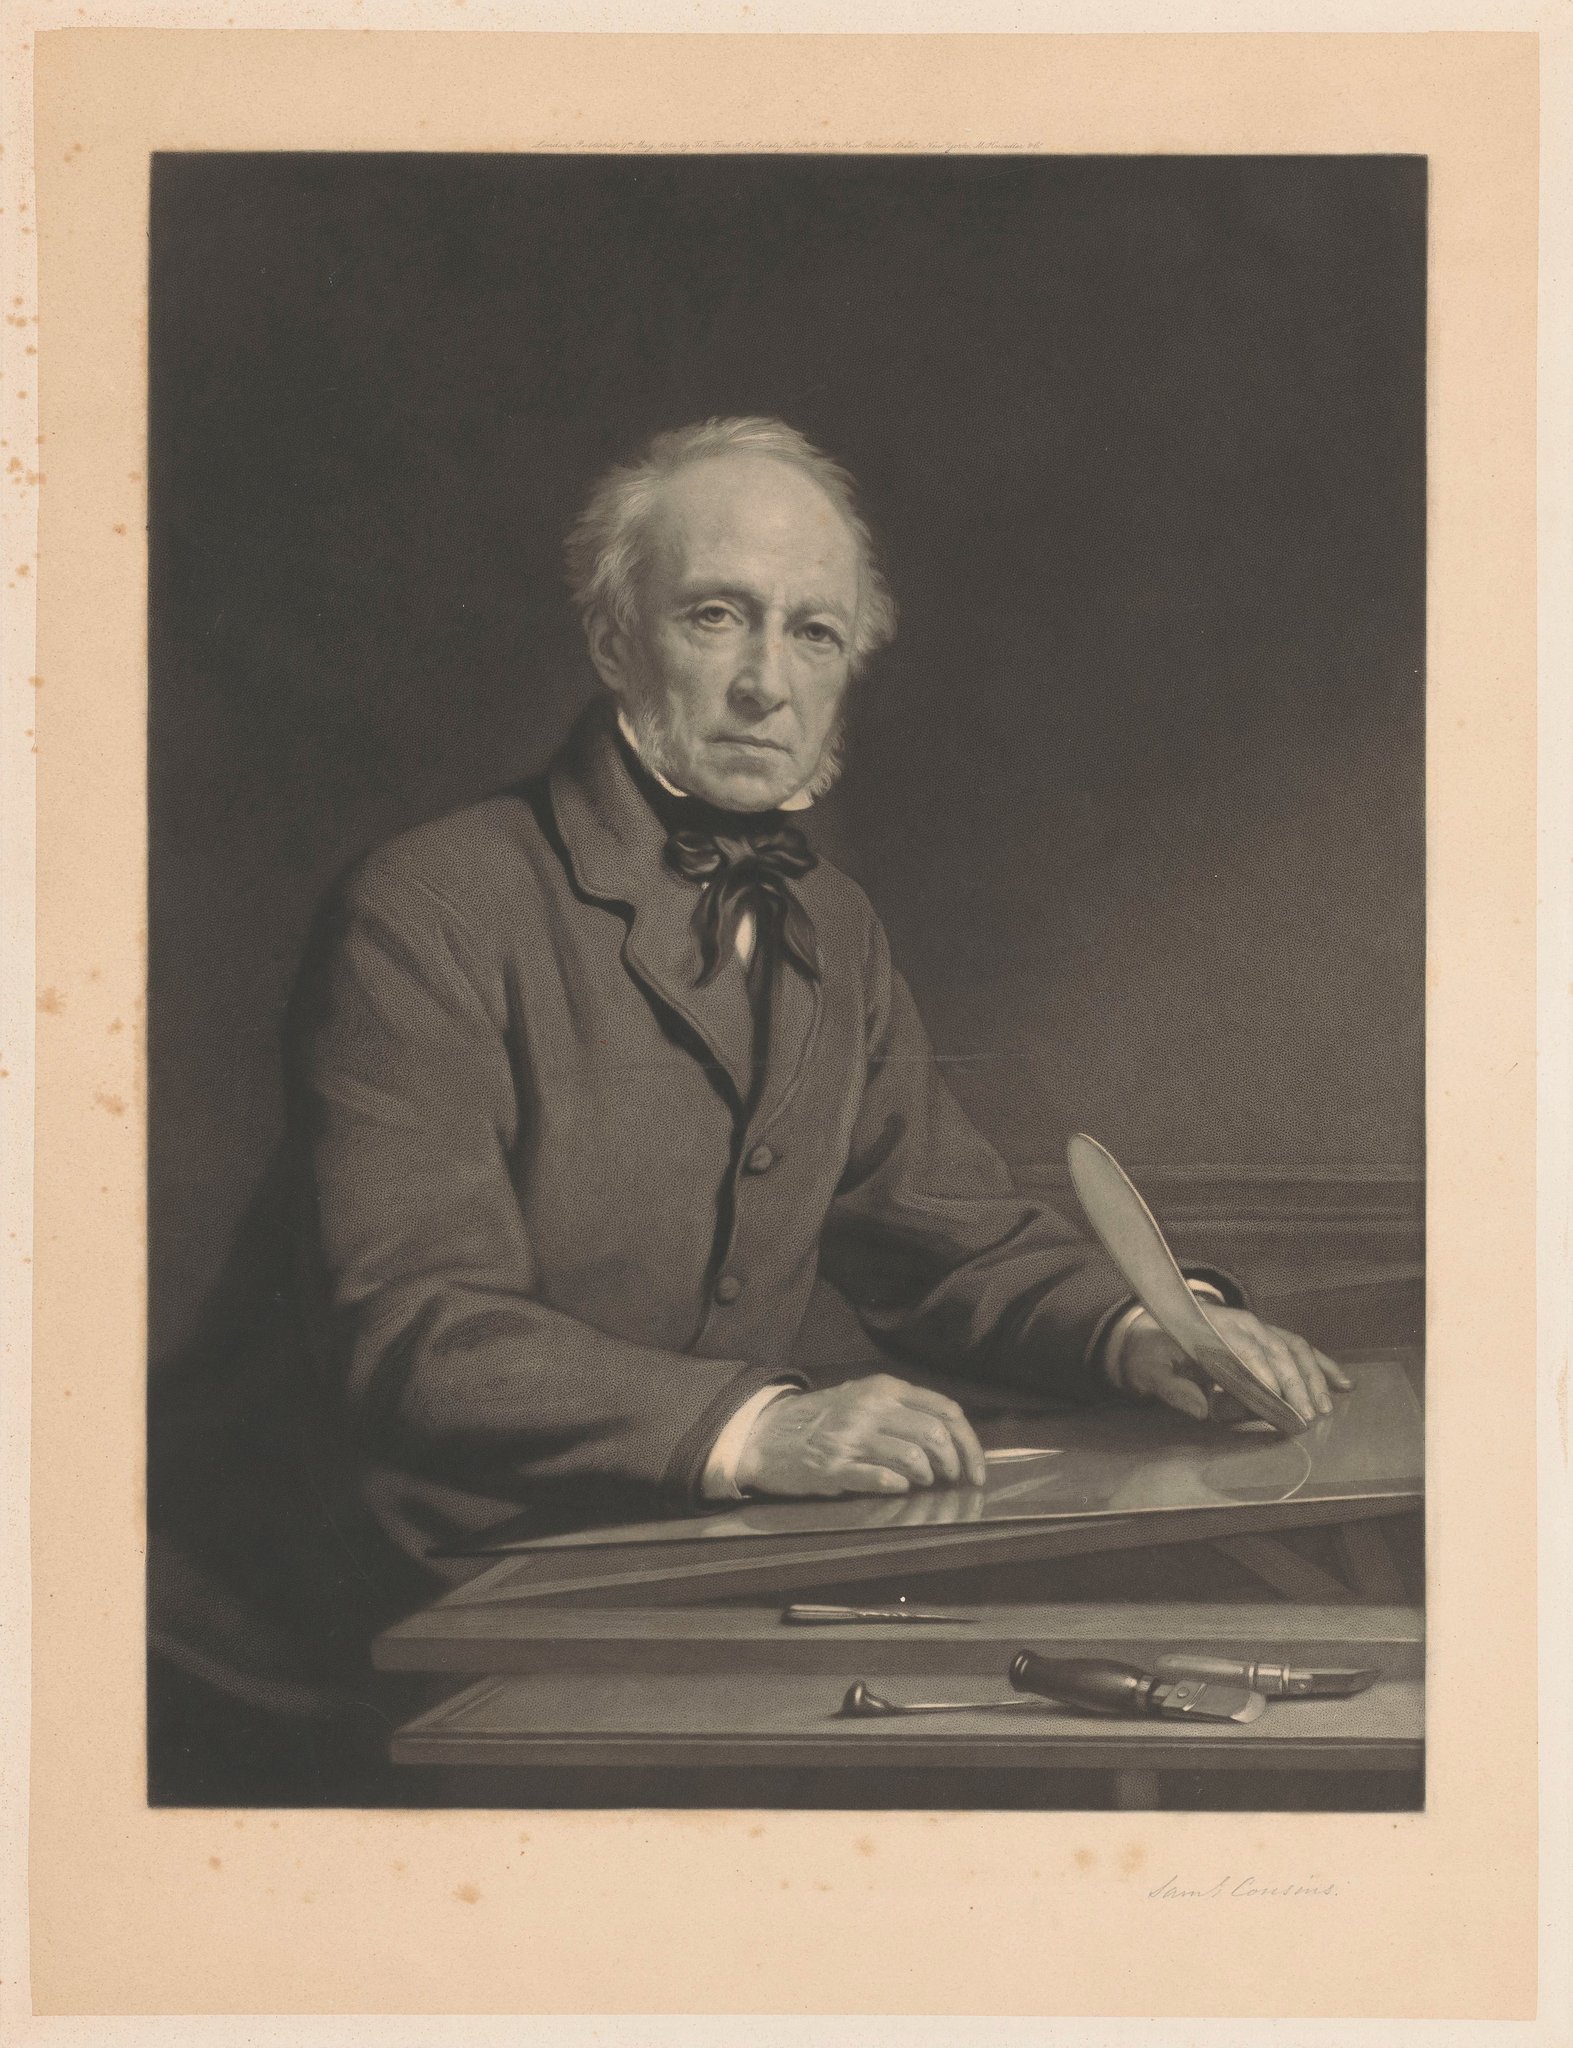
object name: print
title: Portret van Samuel Cousins werkend aan een prent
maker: samuel cousins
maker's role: print maker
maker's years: 1801-1887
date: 1884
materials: paper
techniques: mezzotint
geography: london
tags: print maker, samuel cousins, tools, implements of graphic artist, portrait, self-portrait of graphic artist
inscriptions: collector's mark: Lugt 2228, check stamp: ‘JSY’ Lugt 2050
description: Portret van de Britse prentmaker Samuel Cousins werkend aan een mezzotint. In zijn rechterhand houdt hij een schraapstaal. Op de voorgrond een etsnaald, een burijn en een wiegijzer.